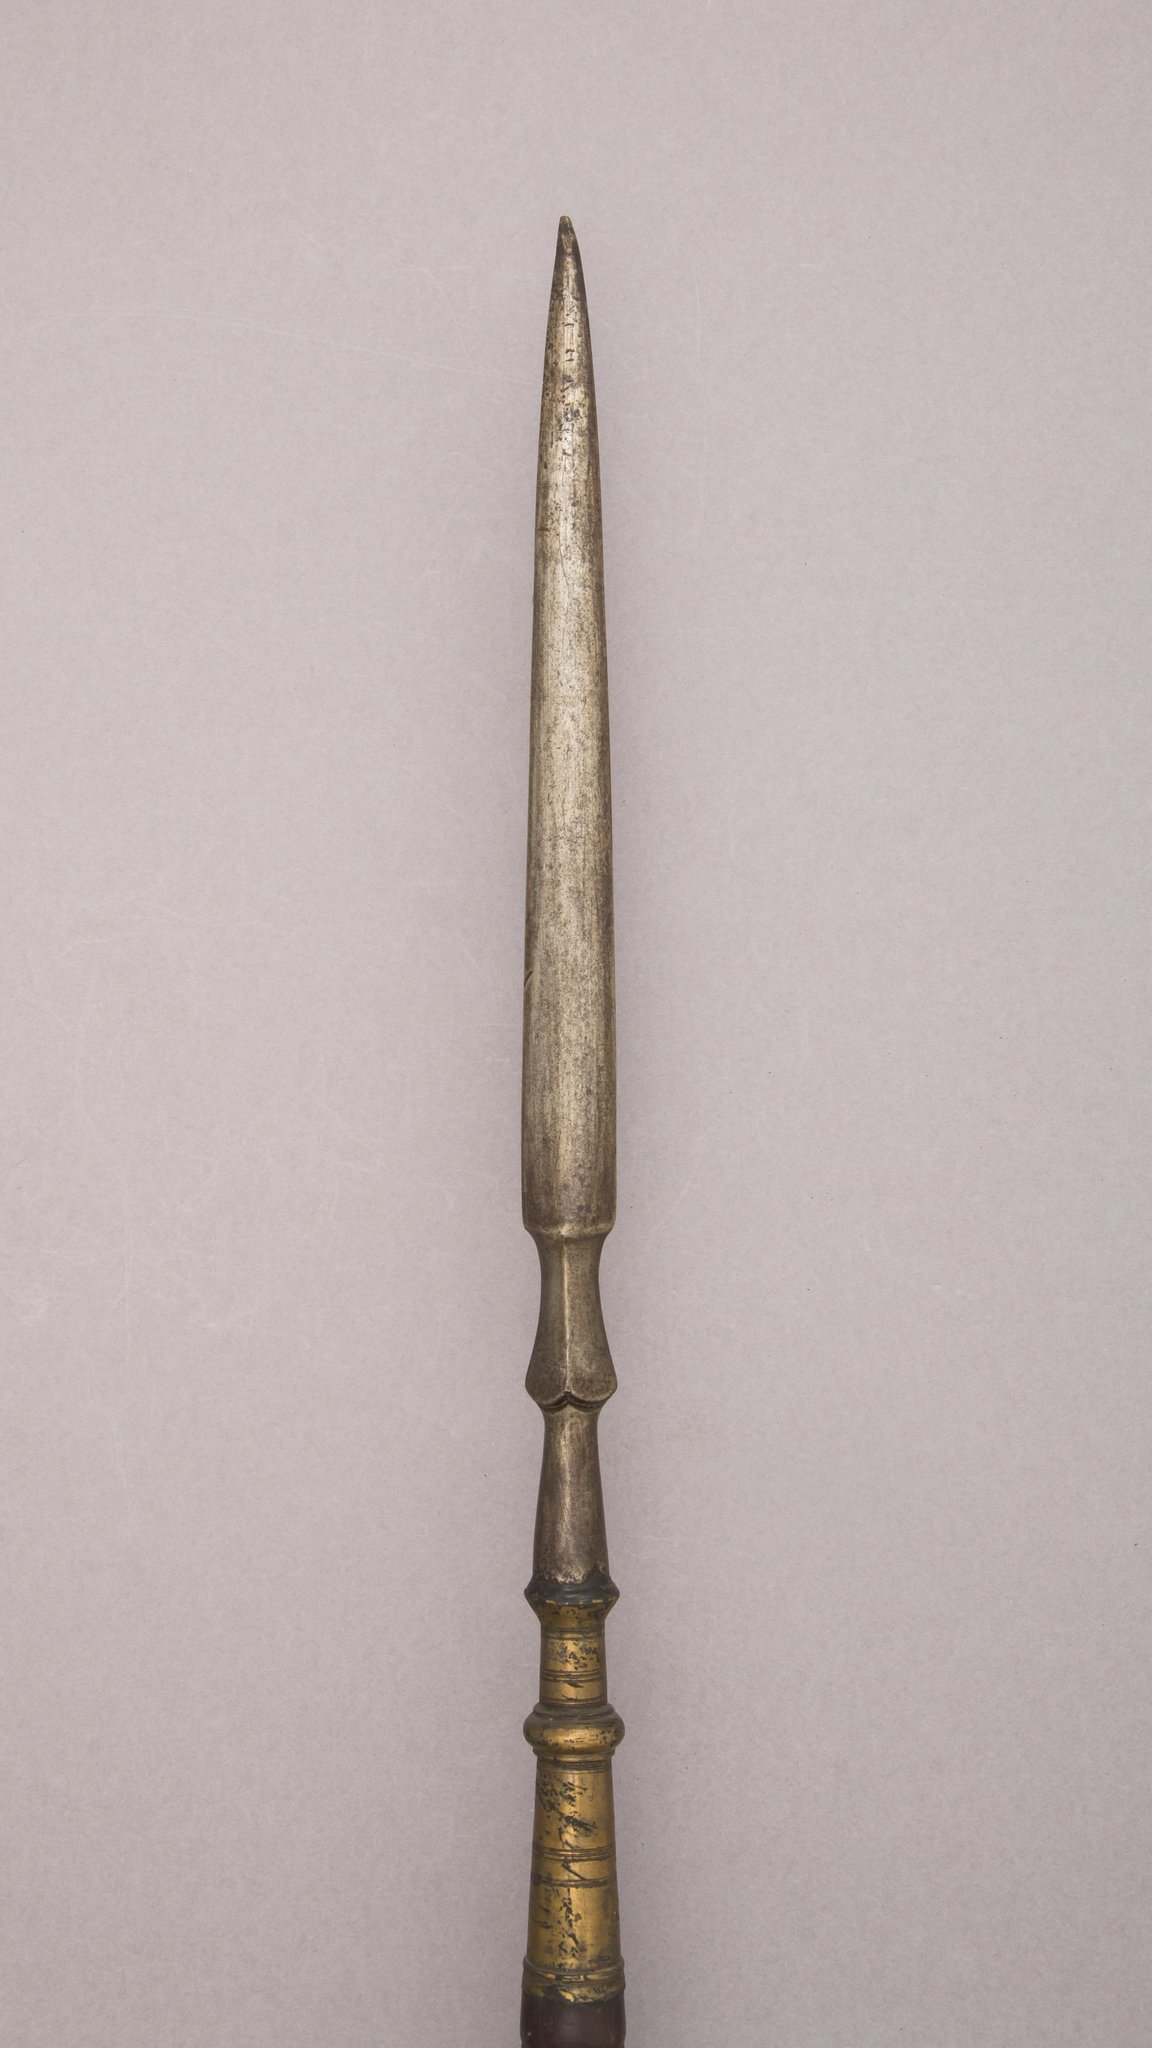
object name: spear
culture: malayan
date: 1701-1900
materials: brass, wood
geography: malaysia